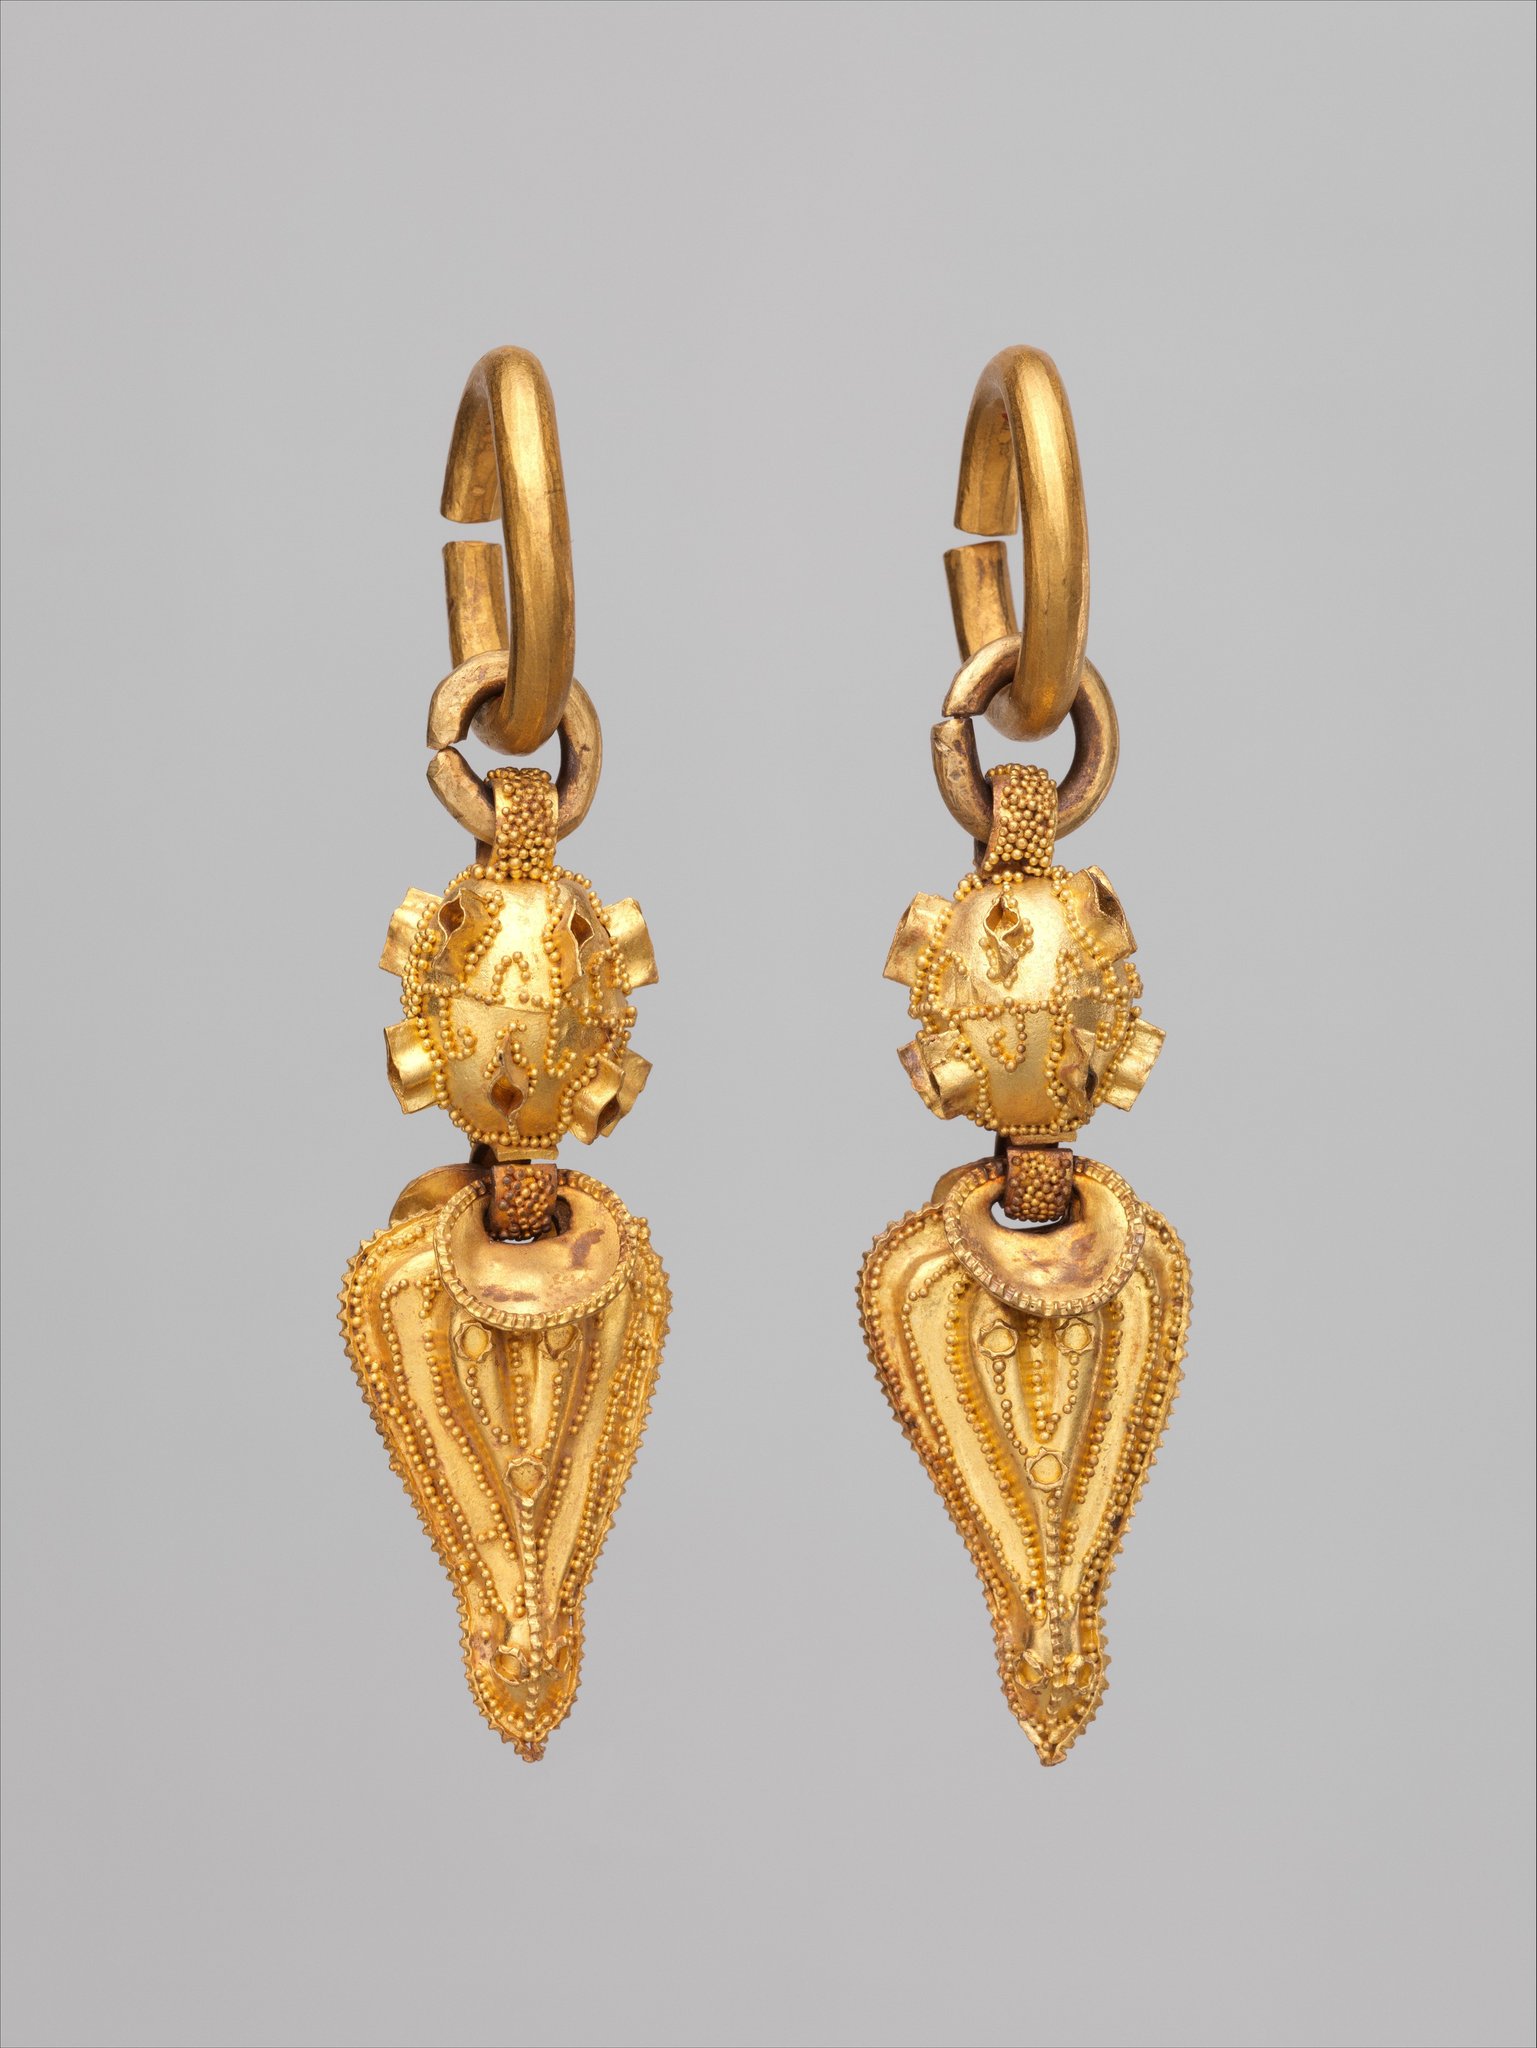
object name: earring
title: Earring (one of a pair)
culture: korean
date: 401-500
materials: gold